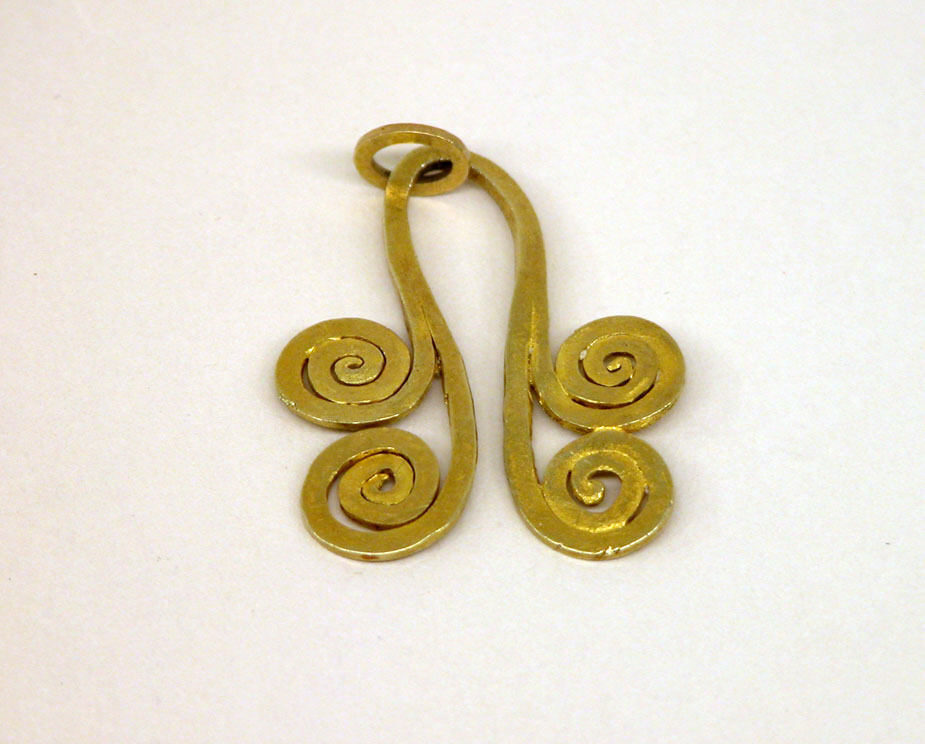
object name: pendant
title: Pendant Composed of Two Sets of Volutes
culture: indonesian, javanese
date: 201-300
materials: gold